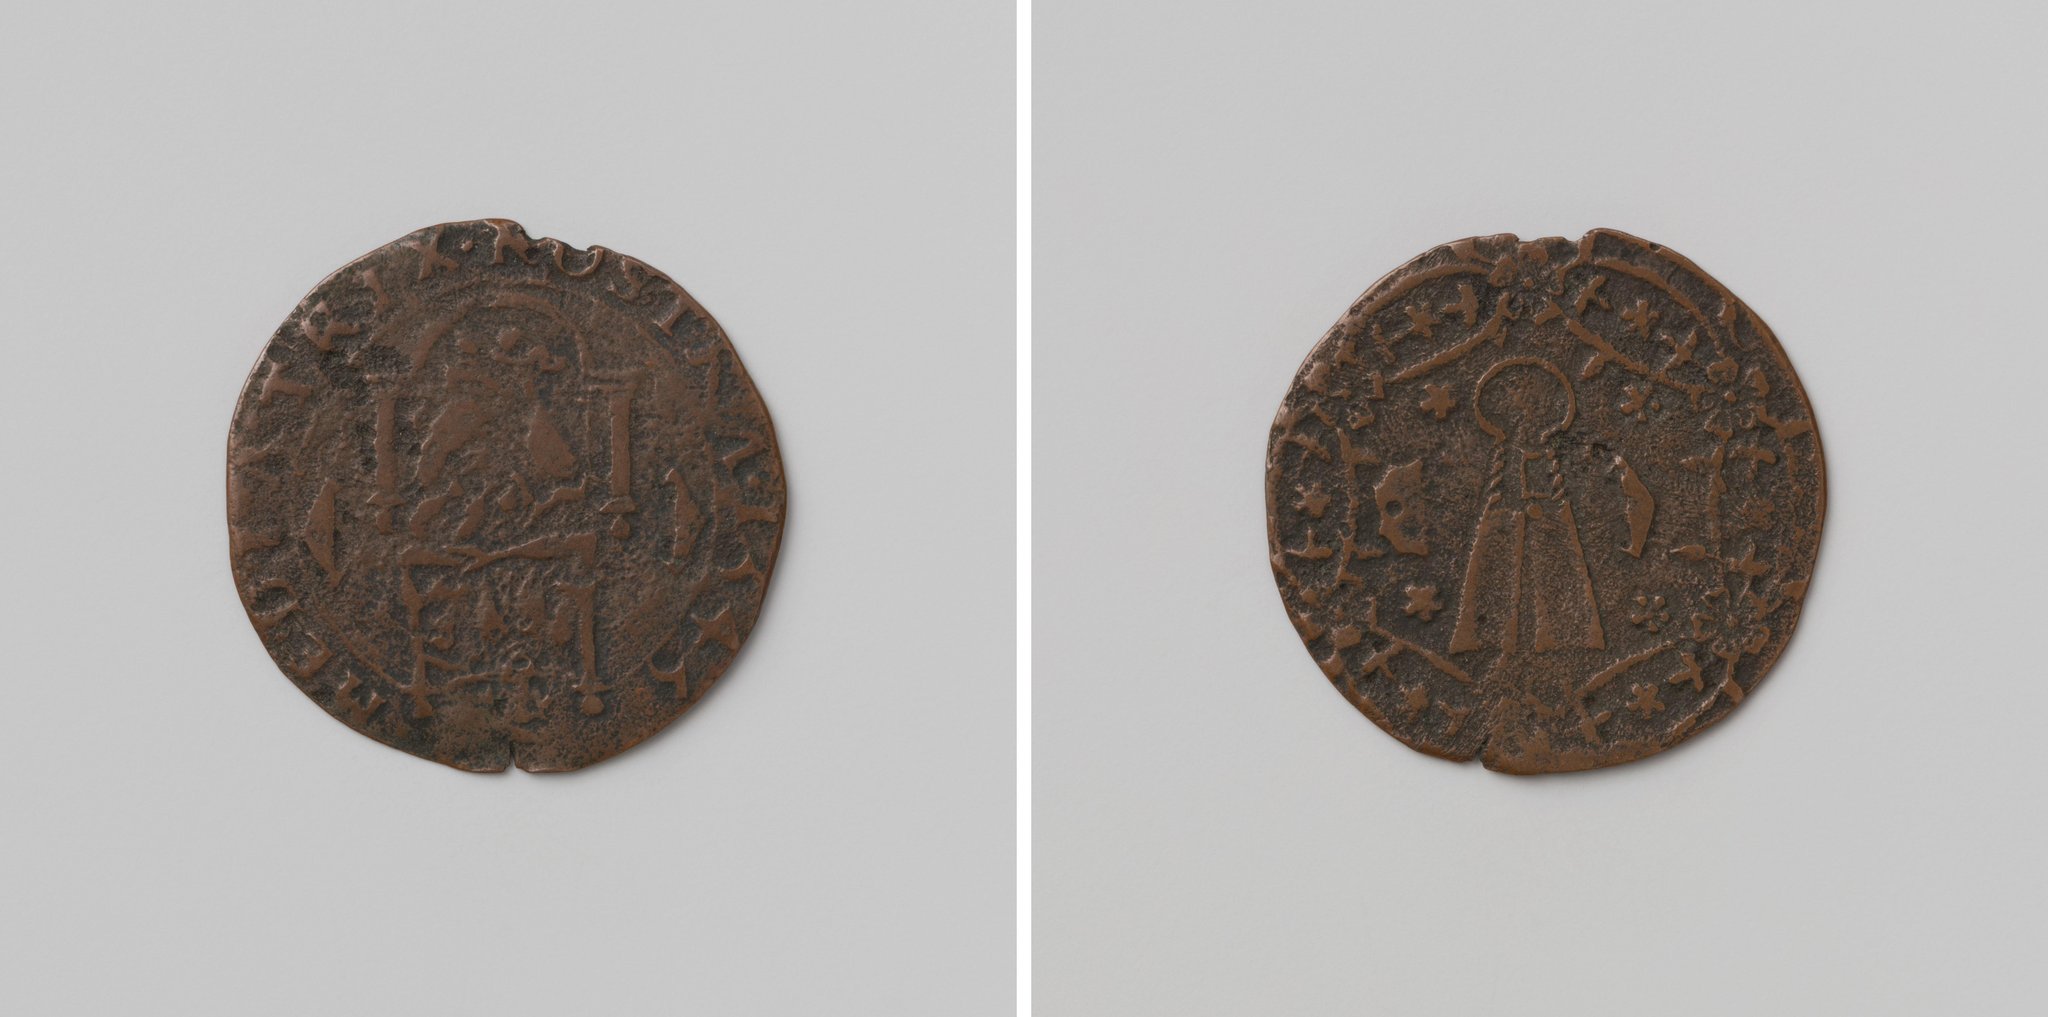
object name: medal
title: Droogscheerdersgilde van Antwerpen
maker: Anonymous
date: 1545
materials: copper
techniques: striking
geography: antwerp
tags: antwerp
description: Koperen penning. Voorzijde: vrouw met kind op arm, zittend op zetel tussen twee langwerpige, driehoekige voorwerpen binnen omschrift. Keerzijde: droogscheerdersschaar tussen kam en langwerpig driehoekig voorwerp binnen krans van bladeren en bloemen